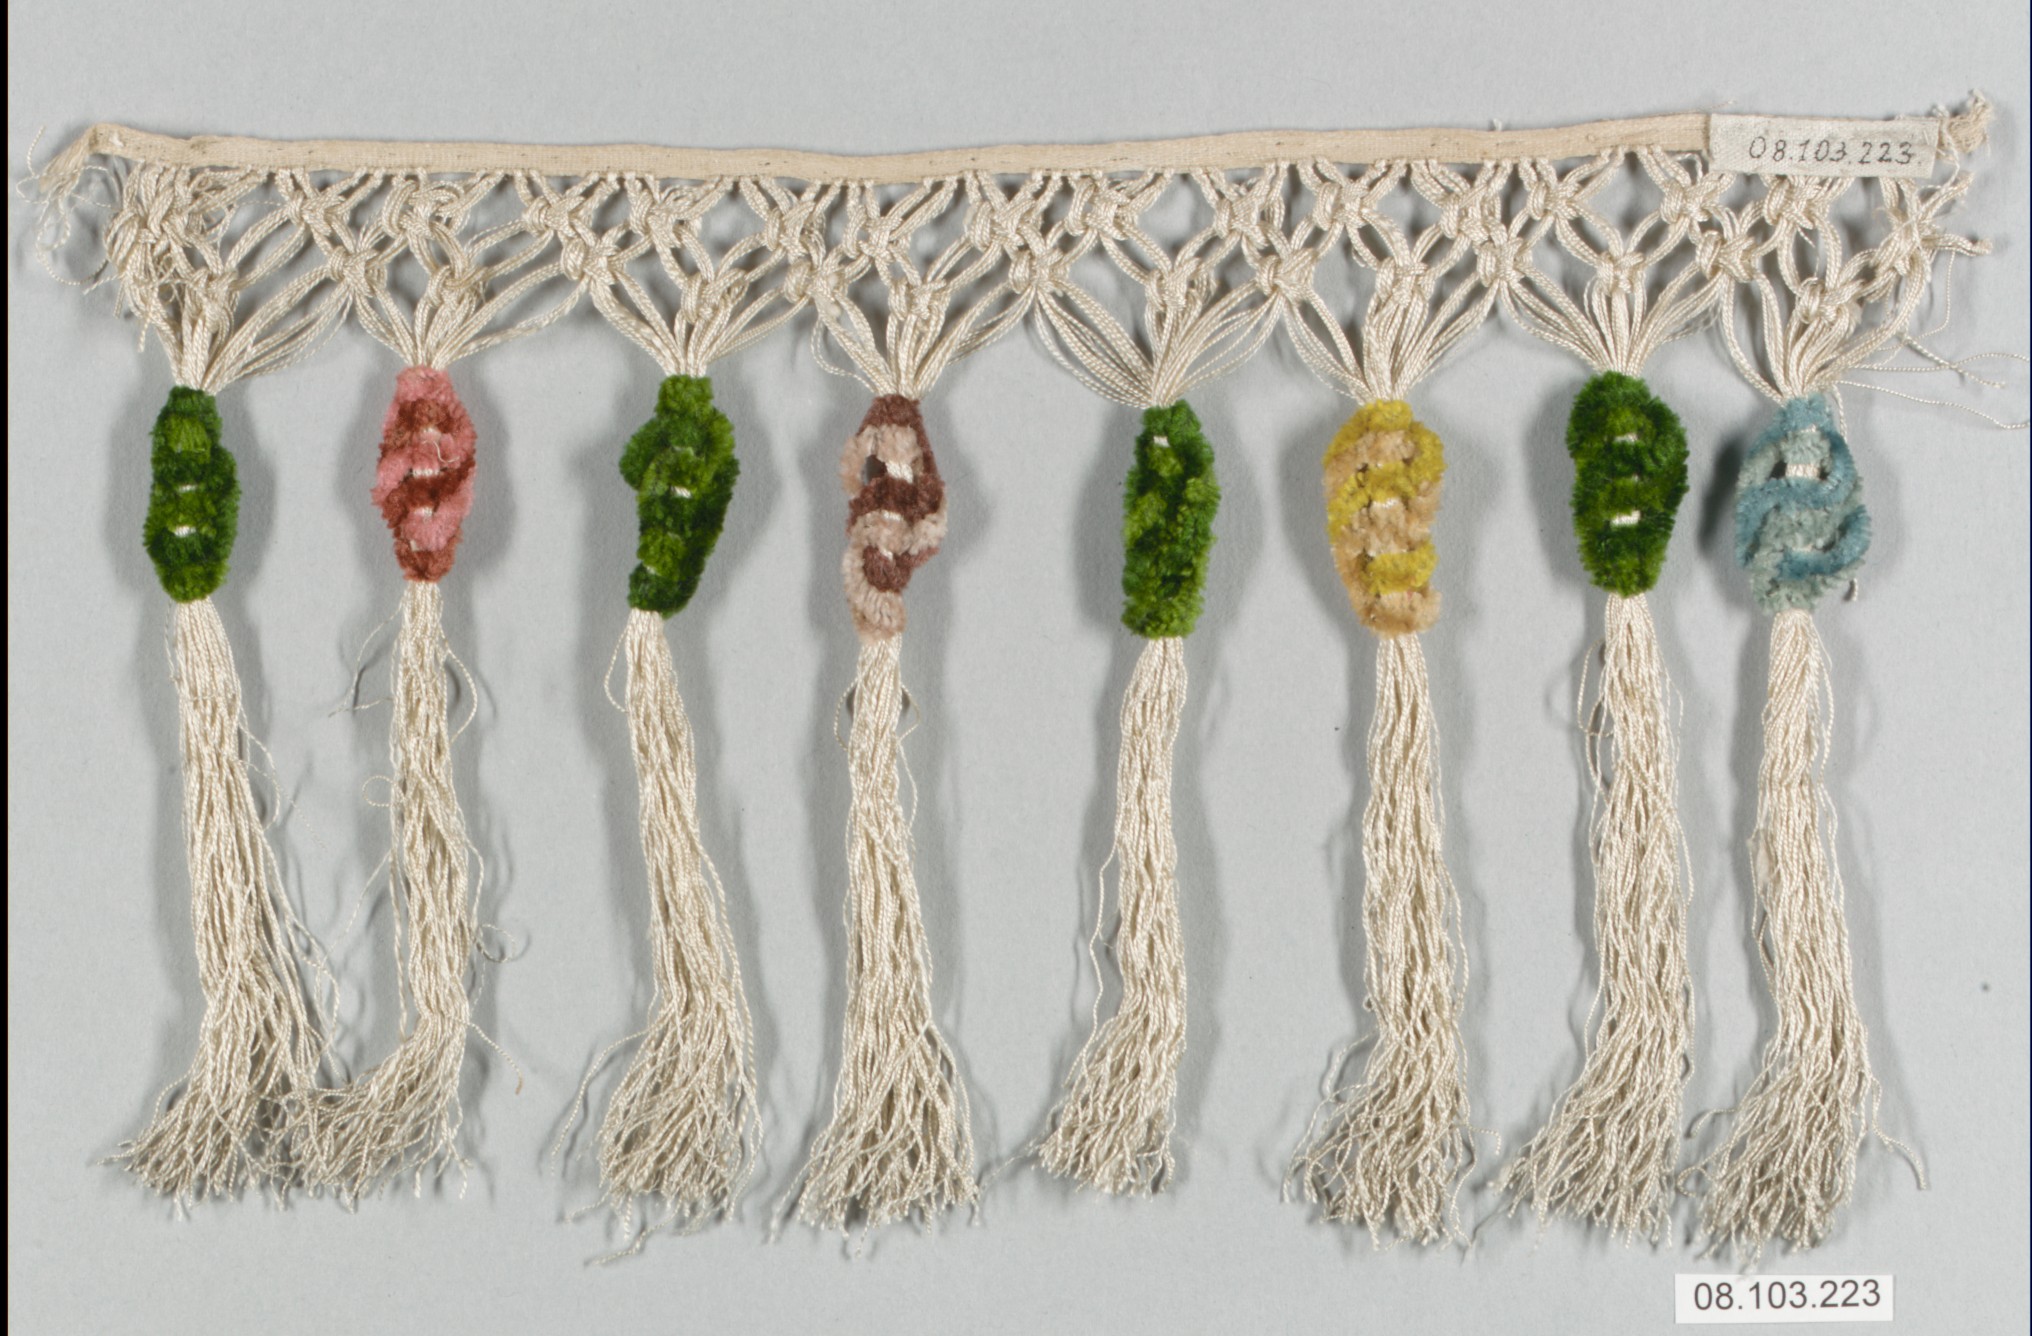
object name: fringe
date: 1801-1900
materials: silk